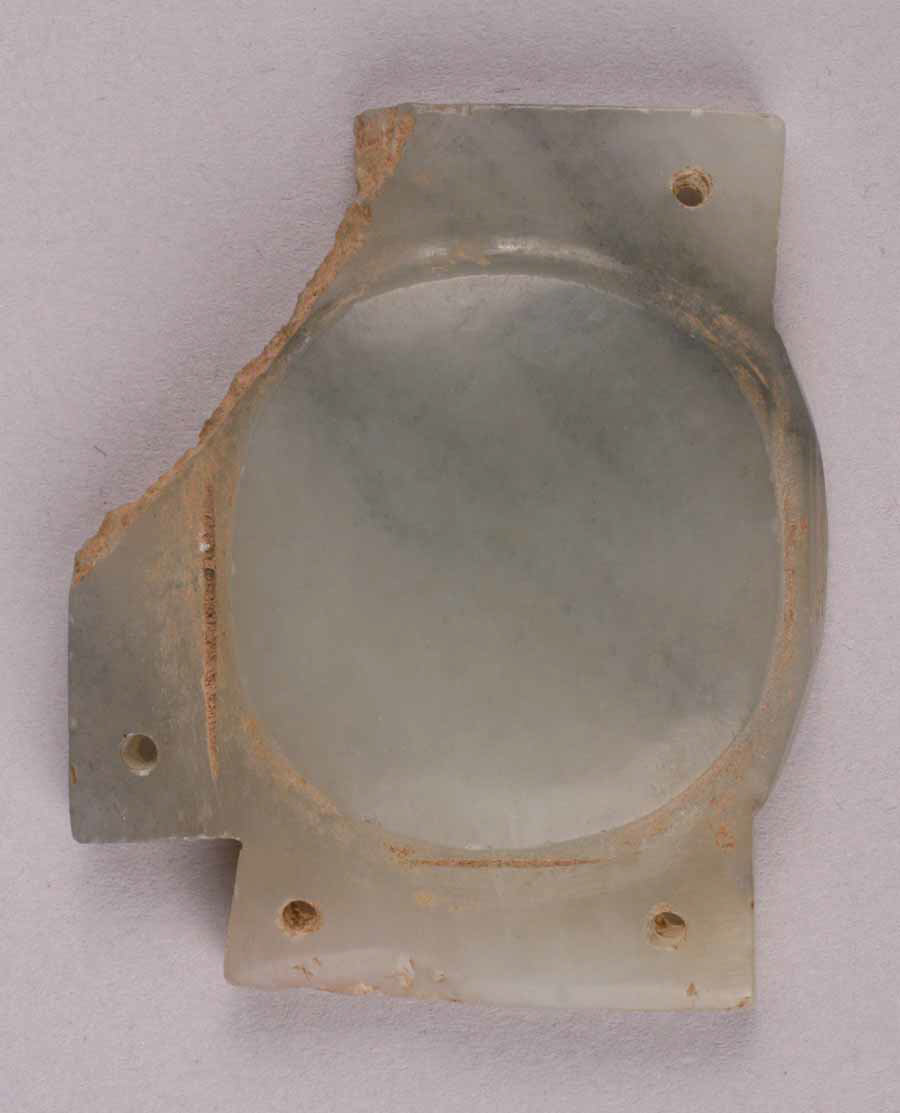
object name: belt fitting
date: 801-1000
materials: jade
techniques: carving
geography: iran